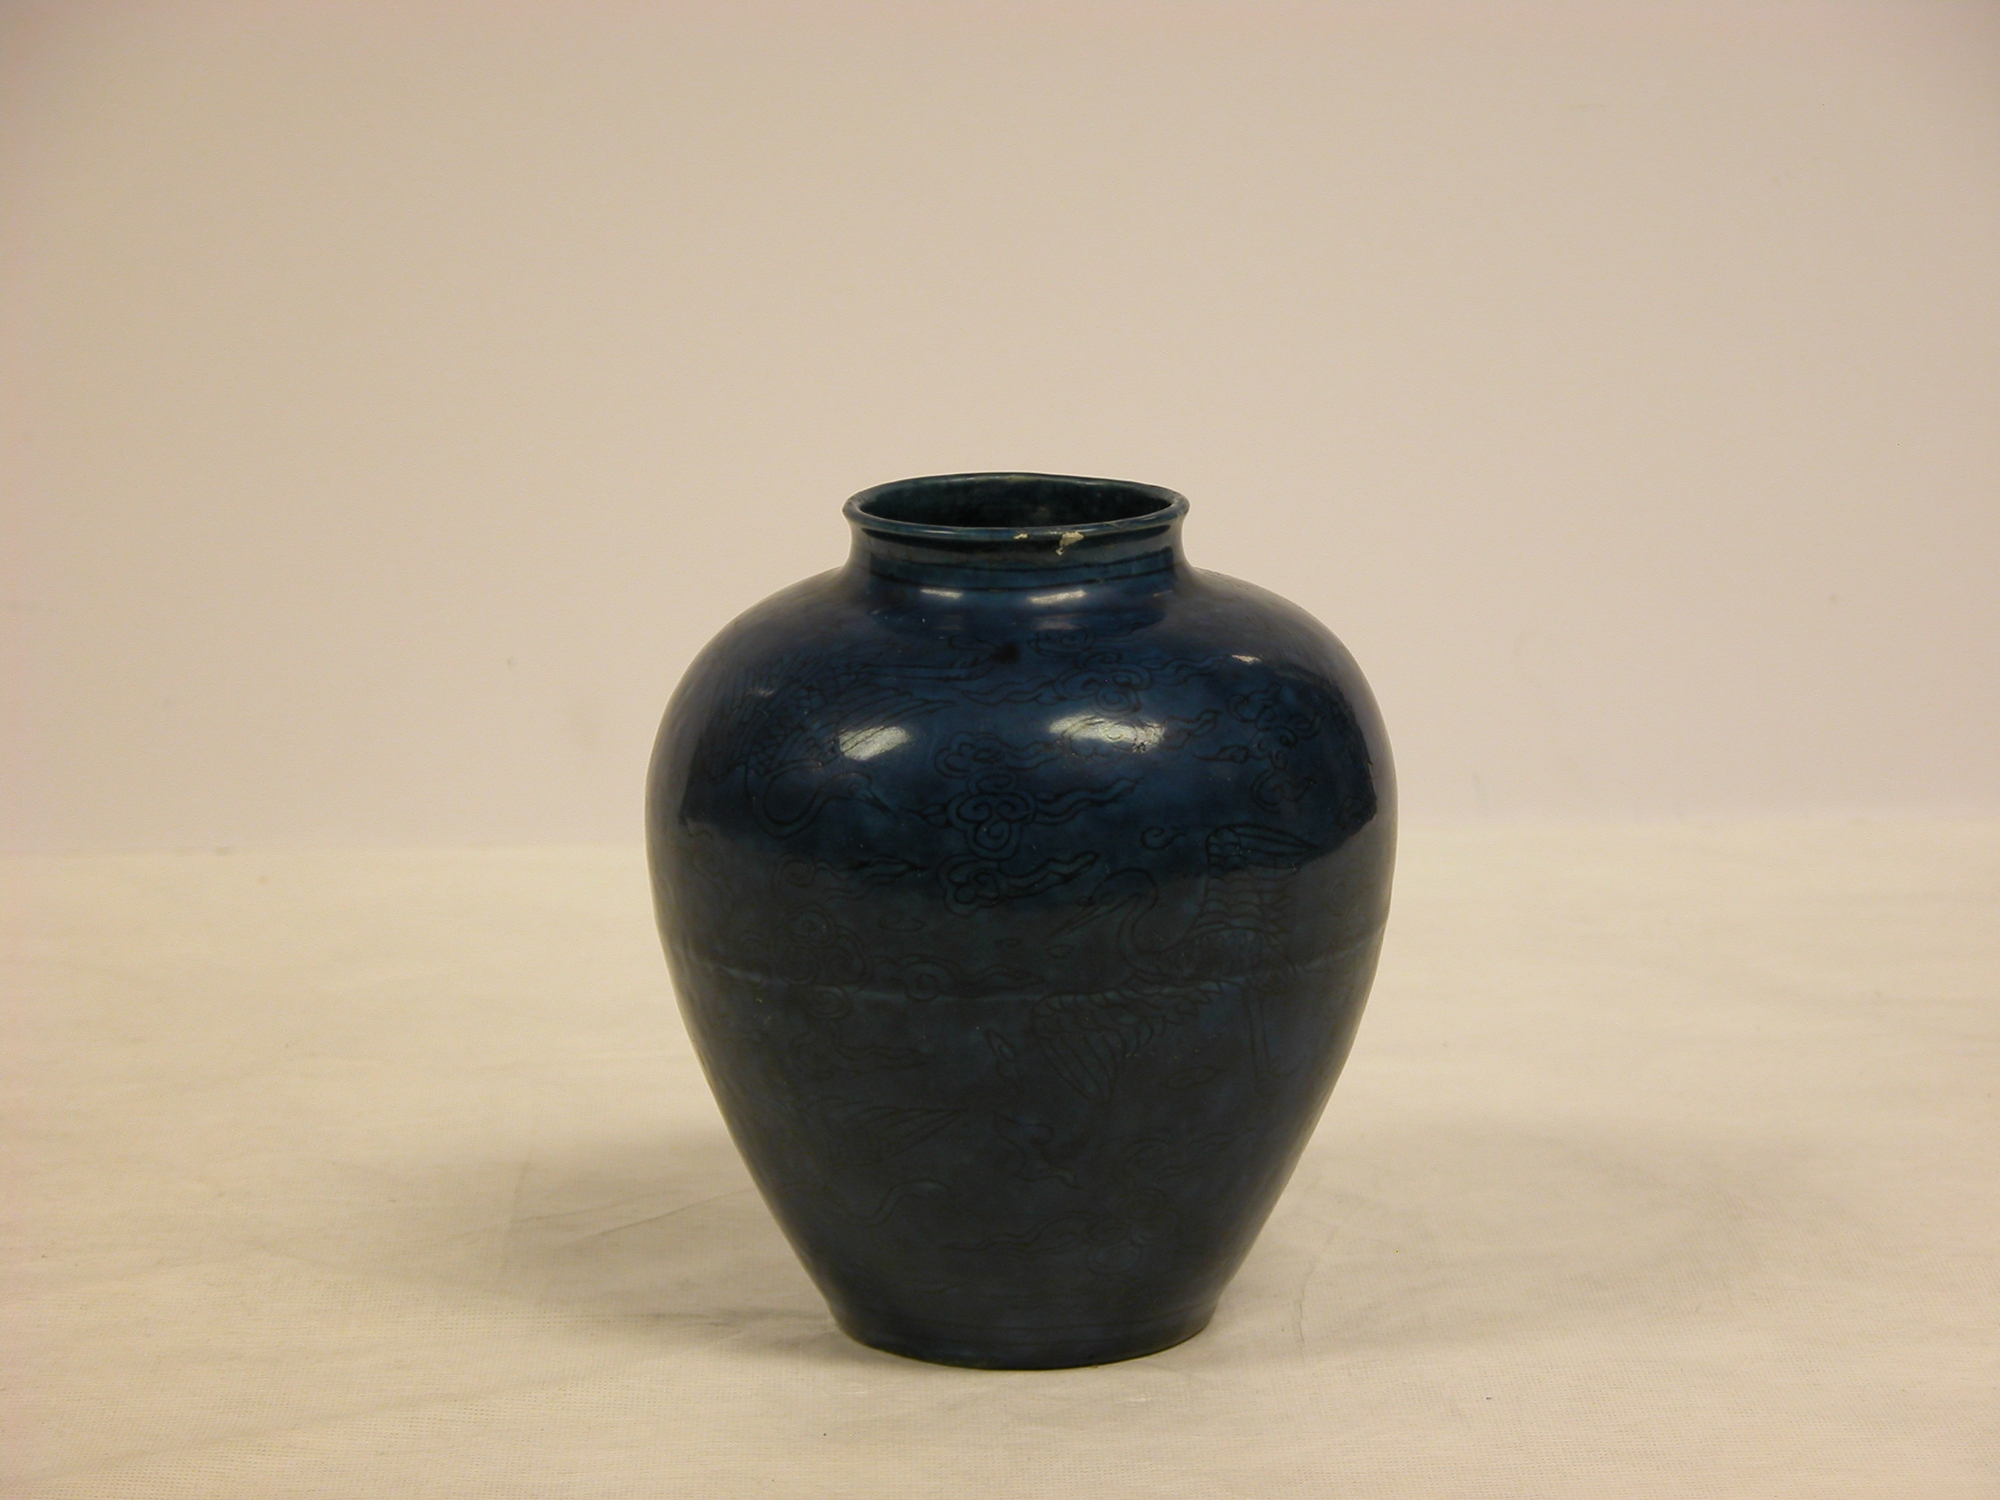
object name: jar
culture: chinese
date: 1522-1566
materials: porcelain